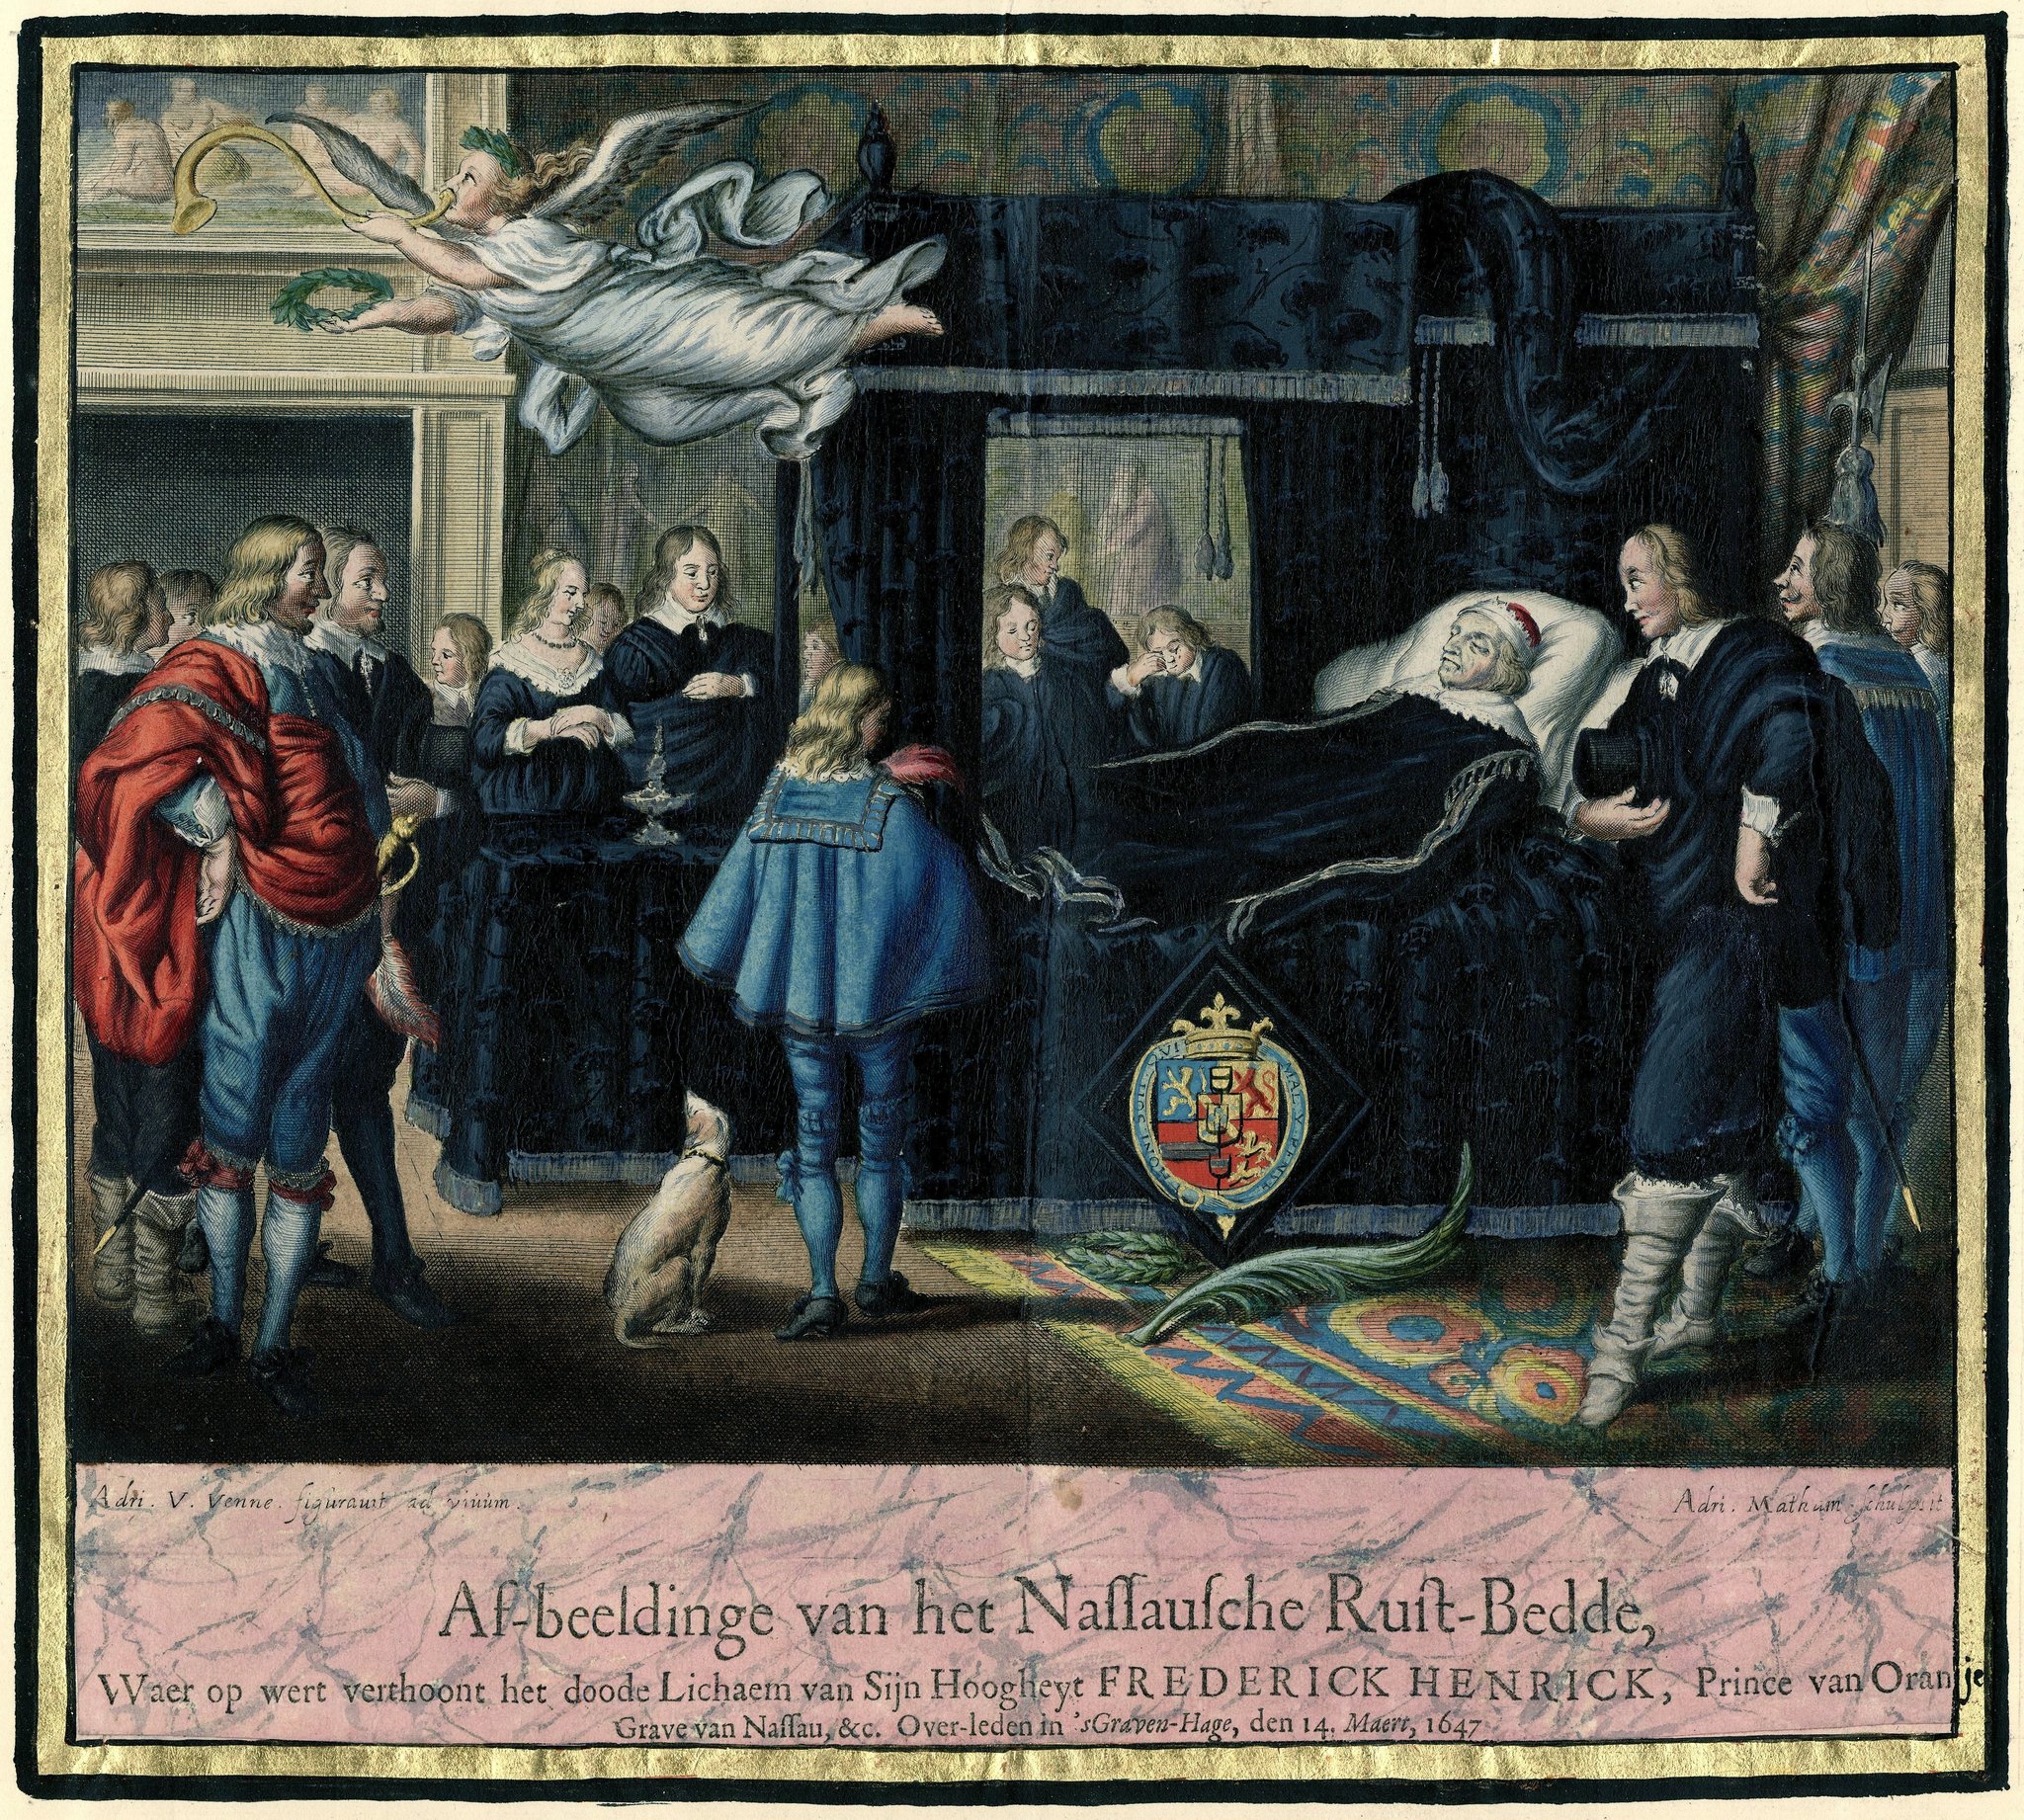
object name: book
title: Begraeffenisse van syne hoogheyt Frederick Henrick. Luxe ingekleurde uitgave van de prenten van de begrafenisstoet van Frederik Hendrik in 1647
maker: adriaen matham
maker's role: draughtsman, print maker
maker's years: 1599-1660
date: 1647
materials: paint, paper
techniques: colour, engraving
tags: delft, the hague, frederick henry (prince of orange), the death of frederick henry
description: De overleden prins Frederik Hendrik op zijn sterfbed. Om het bed staan leden van de familie en vrienden. Boven vliegt de Faam weg om het nieuws van het overlijden van de prins bekend te maken. Ingekleurde prent in gouden omlijsting en ingeplakt in de luxe editie uit ca. 1755 van het boek 'Begraeffenisse van syne hoogheyt Frederick Henrick' van Pieter Post, uitgegeven te Amsterdam in 1651 (Zie ook RP-P-OB-77.001).